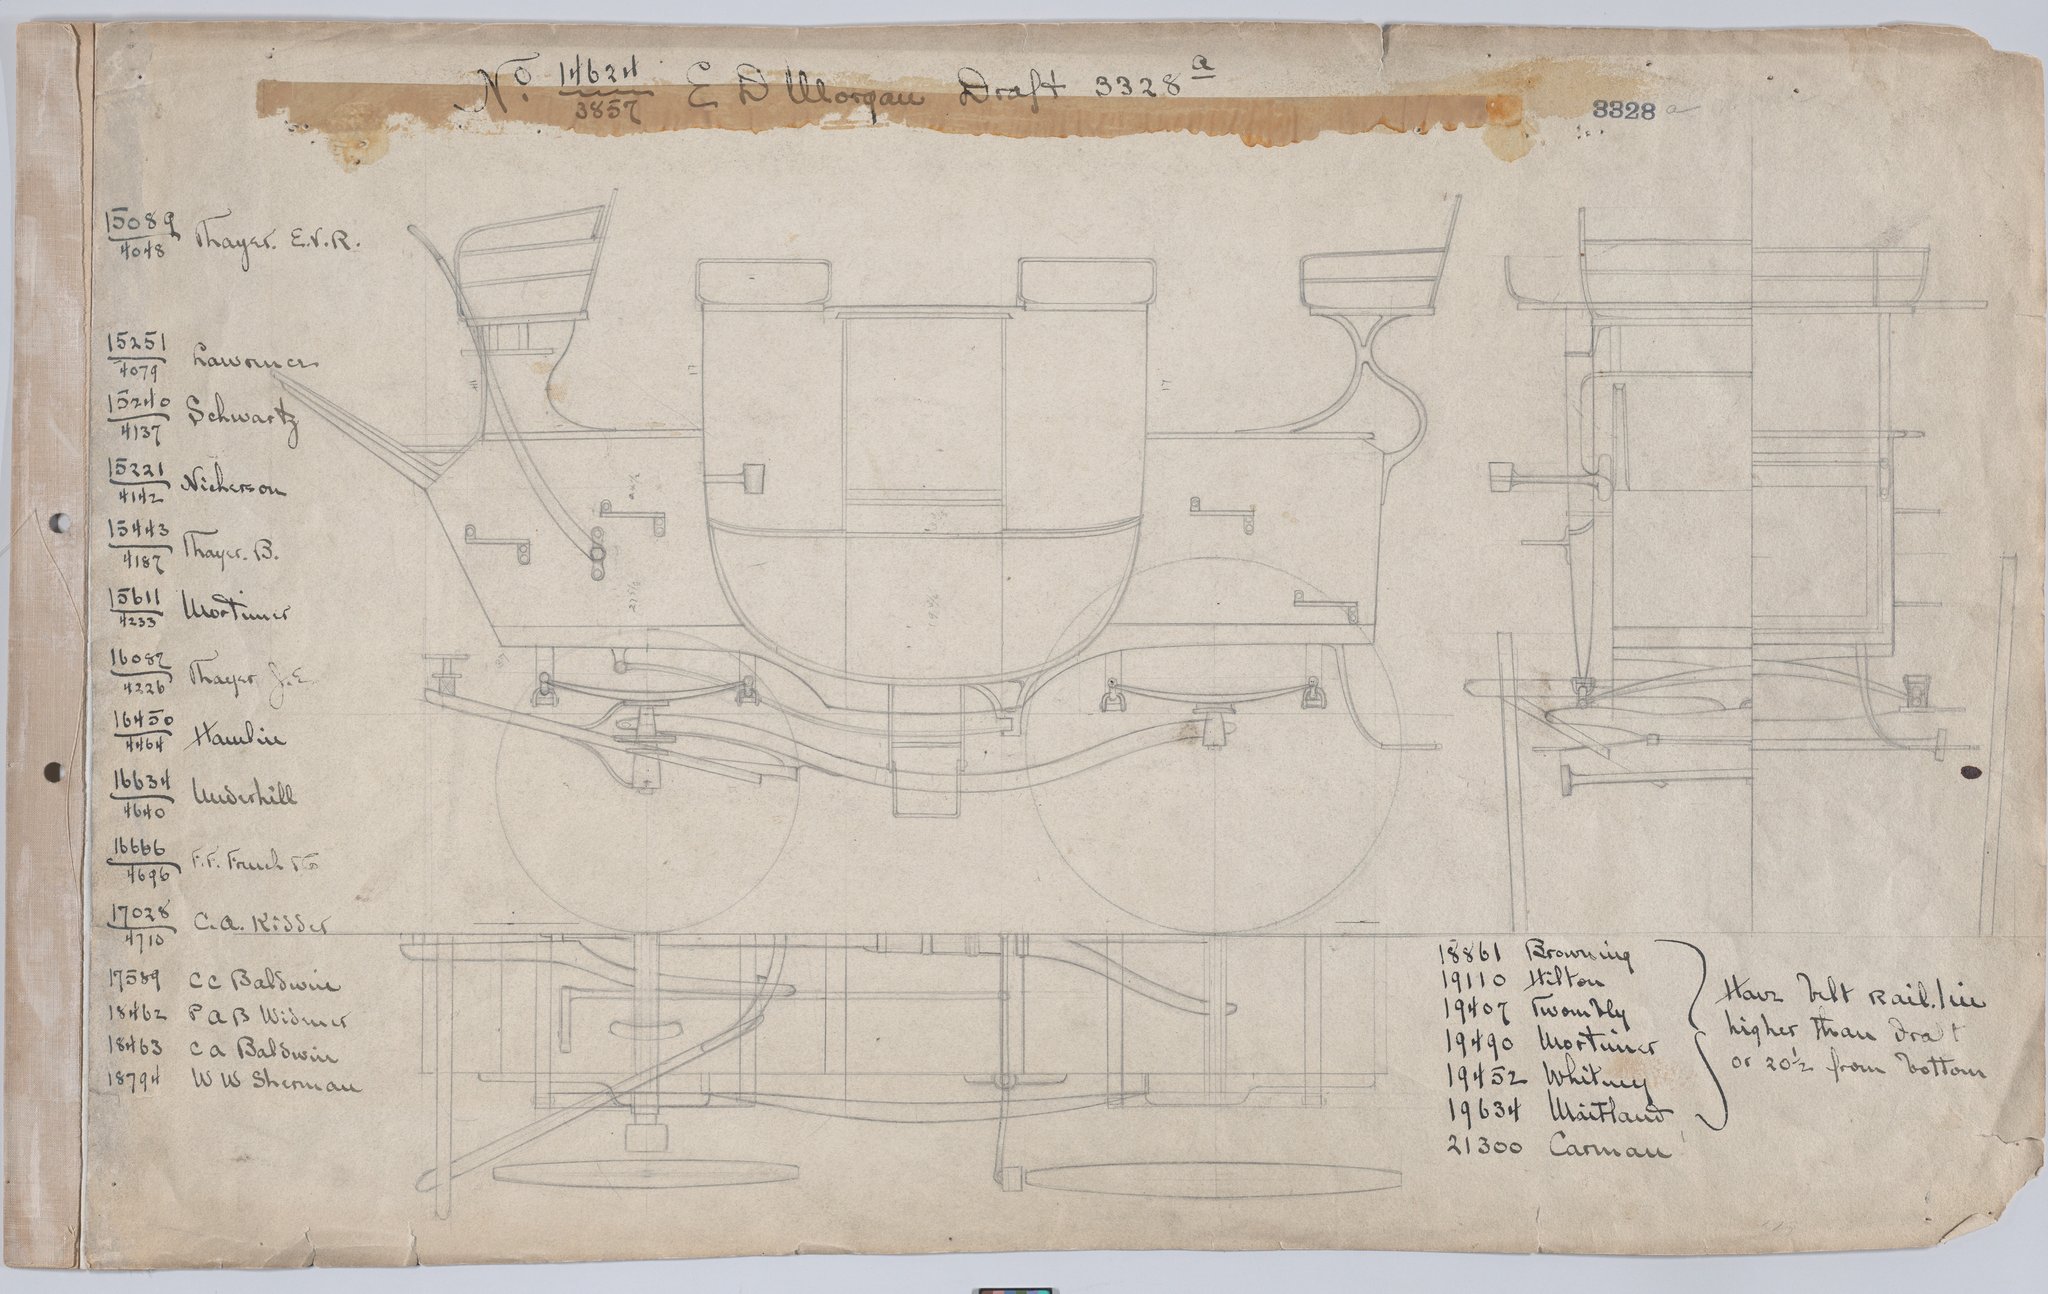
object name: drawing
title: Park Drag #3328a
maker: brewster & co.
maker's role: manufacturer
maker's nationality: american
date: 1877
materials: graphite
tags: carriages